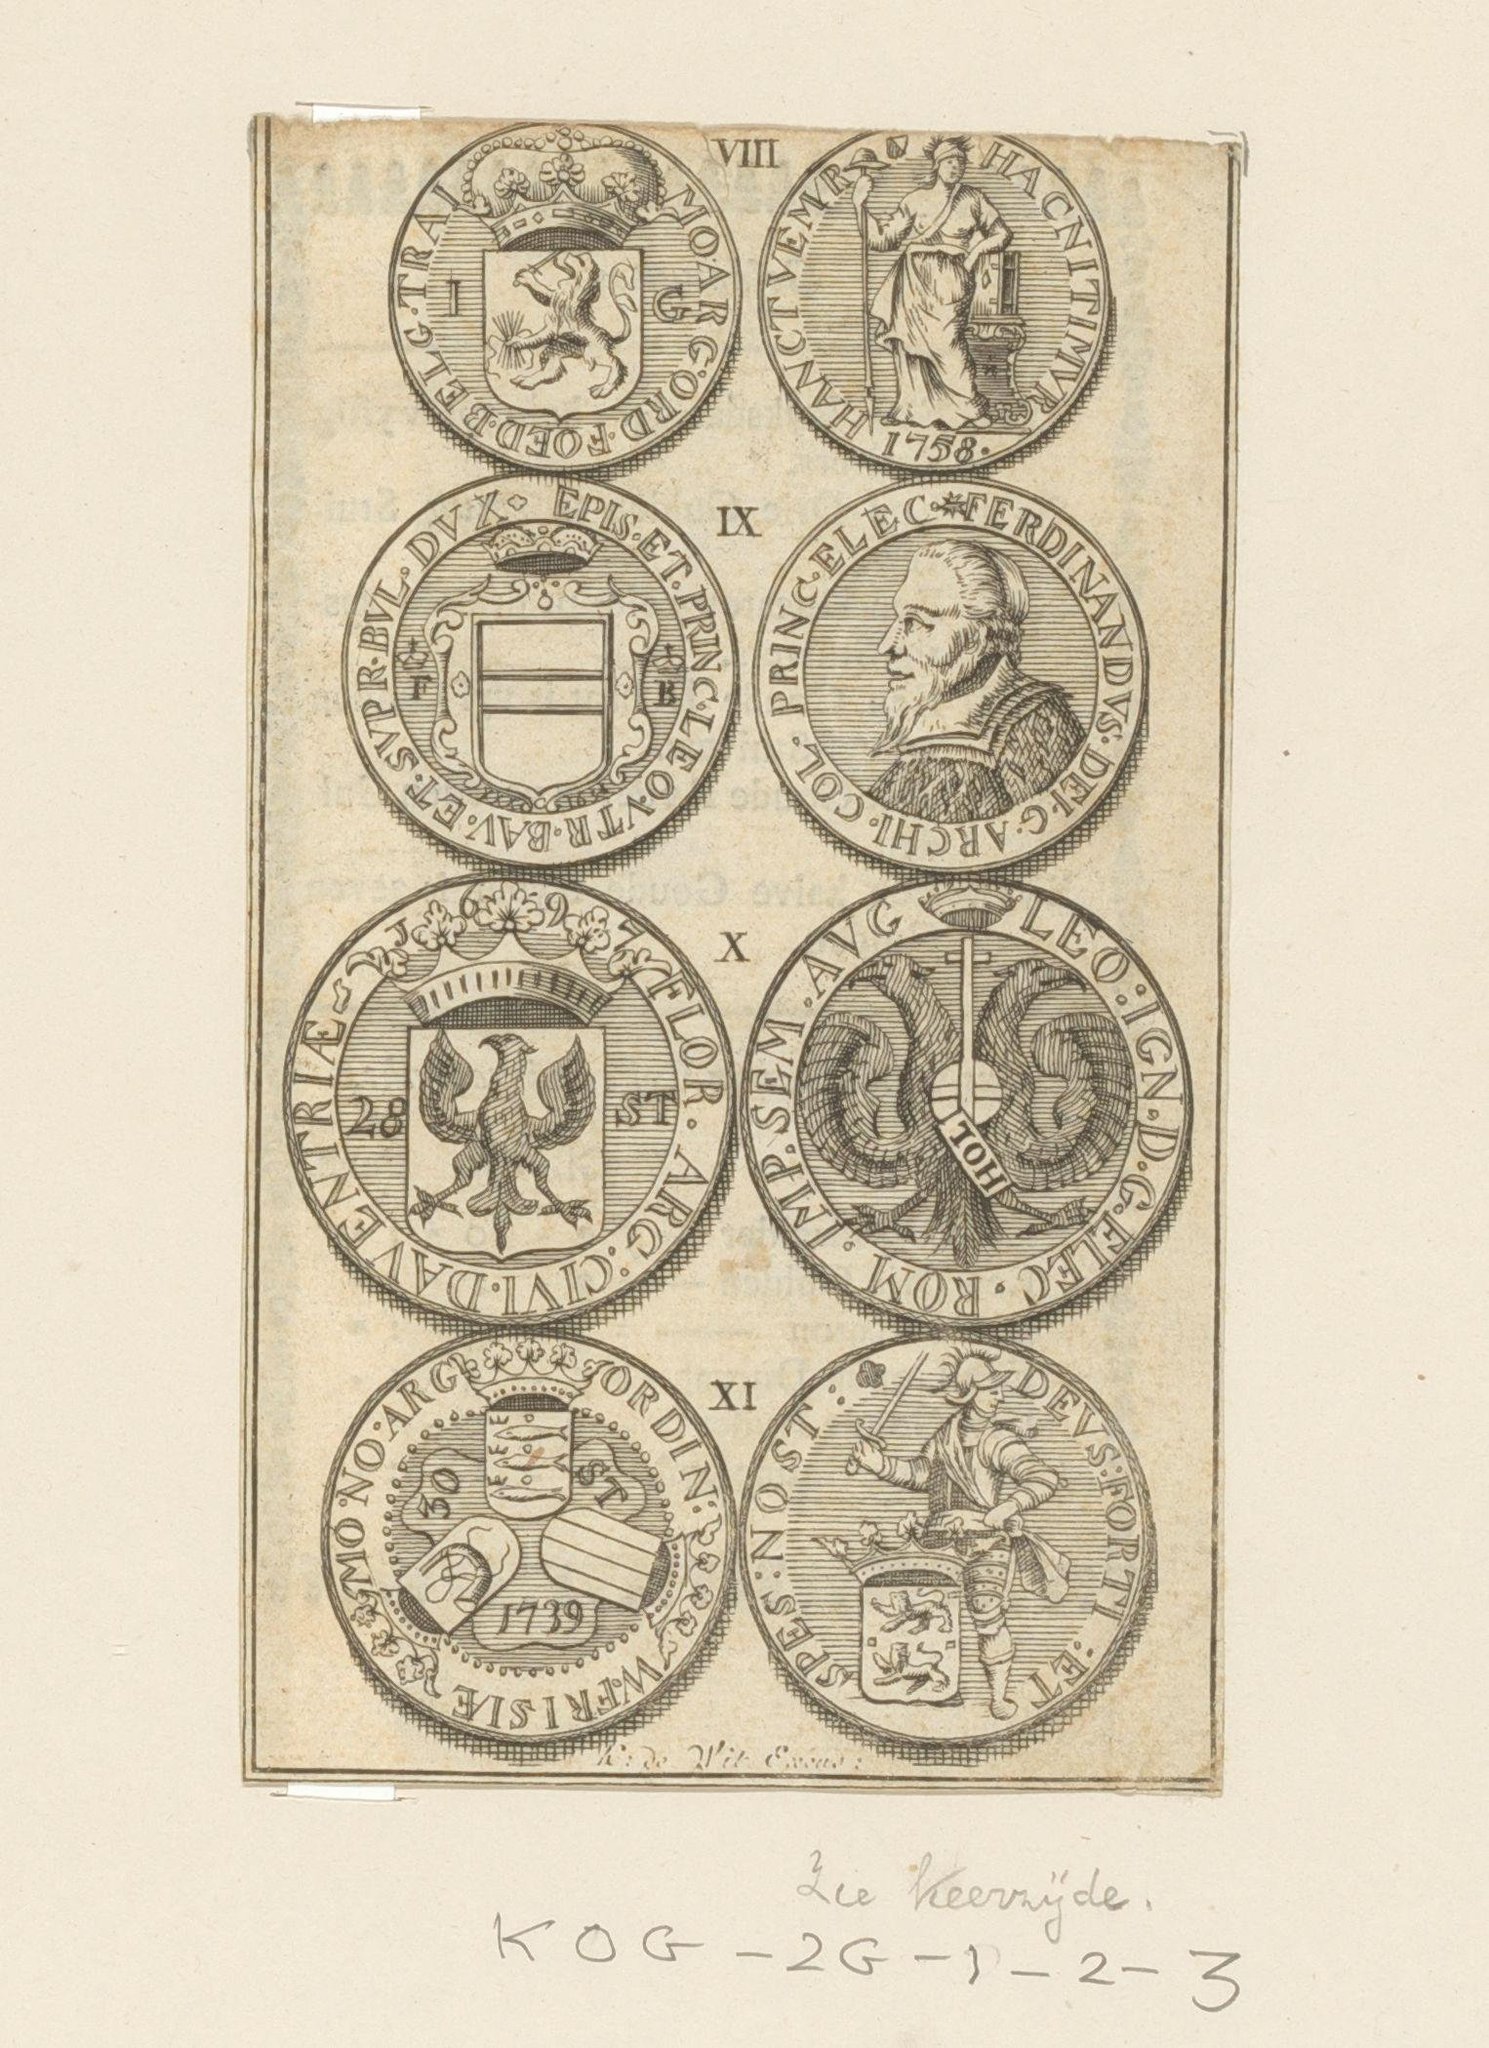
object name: print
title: Vier munten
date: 1758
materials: paper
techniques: engraving, etching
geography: netherlands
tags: coin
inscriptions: collector's mark, collector's mark: Lugt 1641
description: Blad met de voor- en keerzijde van vier munten genummerd VIII-XI, uit de zeventiende en achttiende eeuw. Met Nederlandse tekst op de achterzijde van het blad. Onderwerpsrubrieken binnen de Atlas Zeden en Gewoonten: Regeering, Muntwezen.